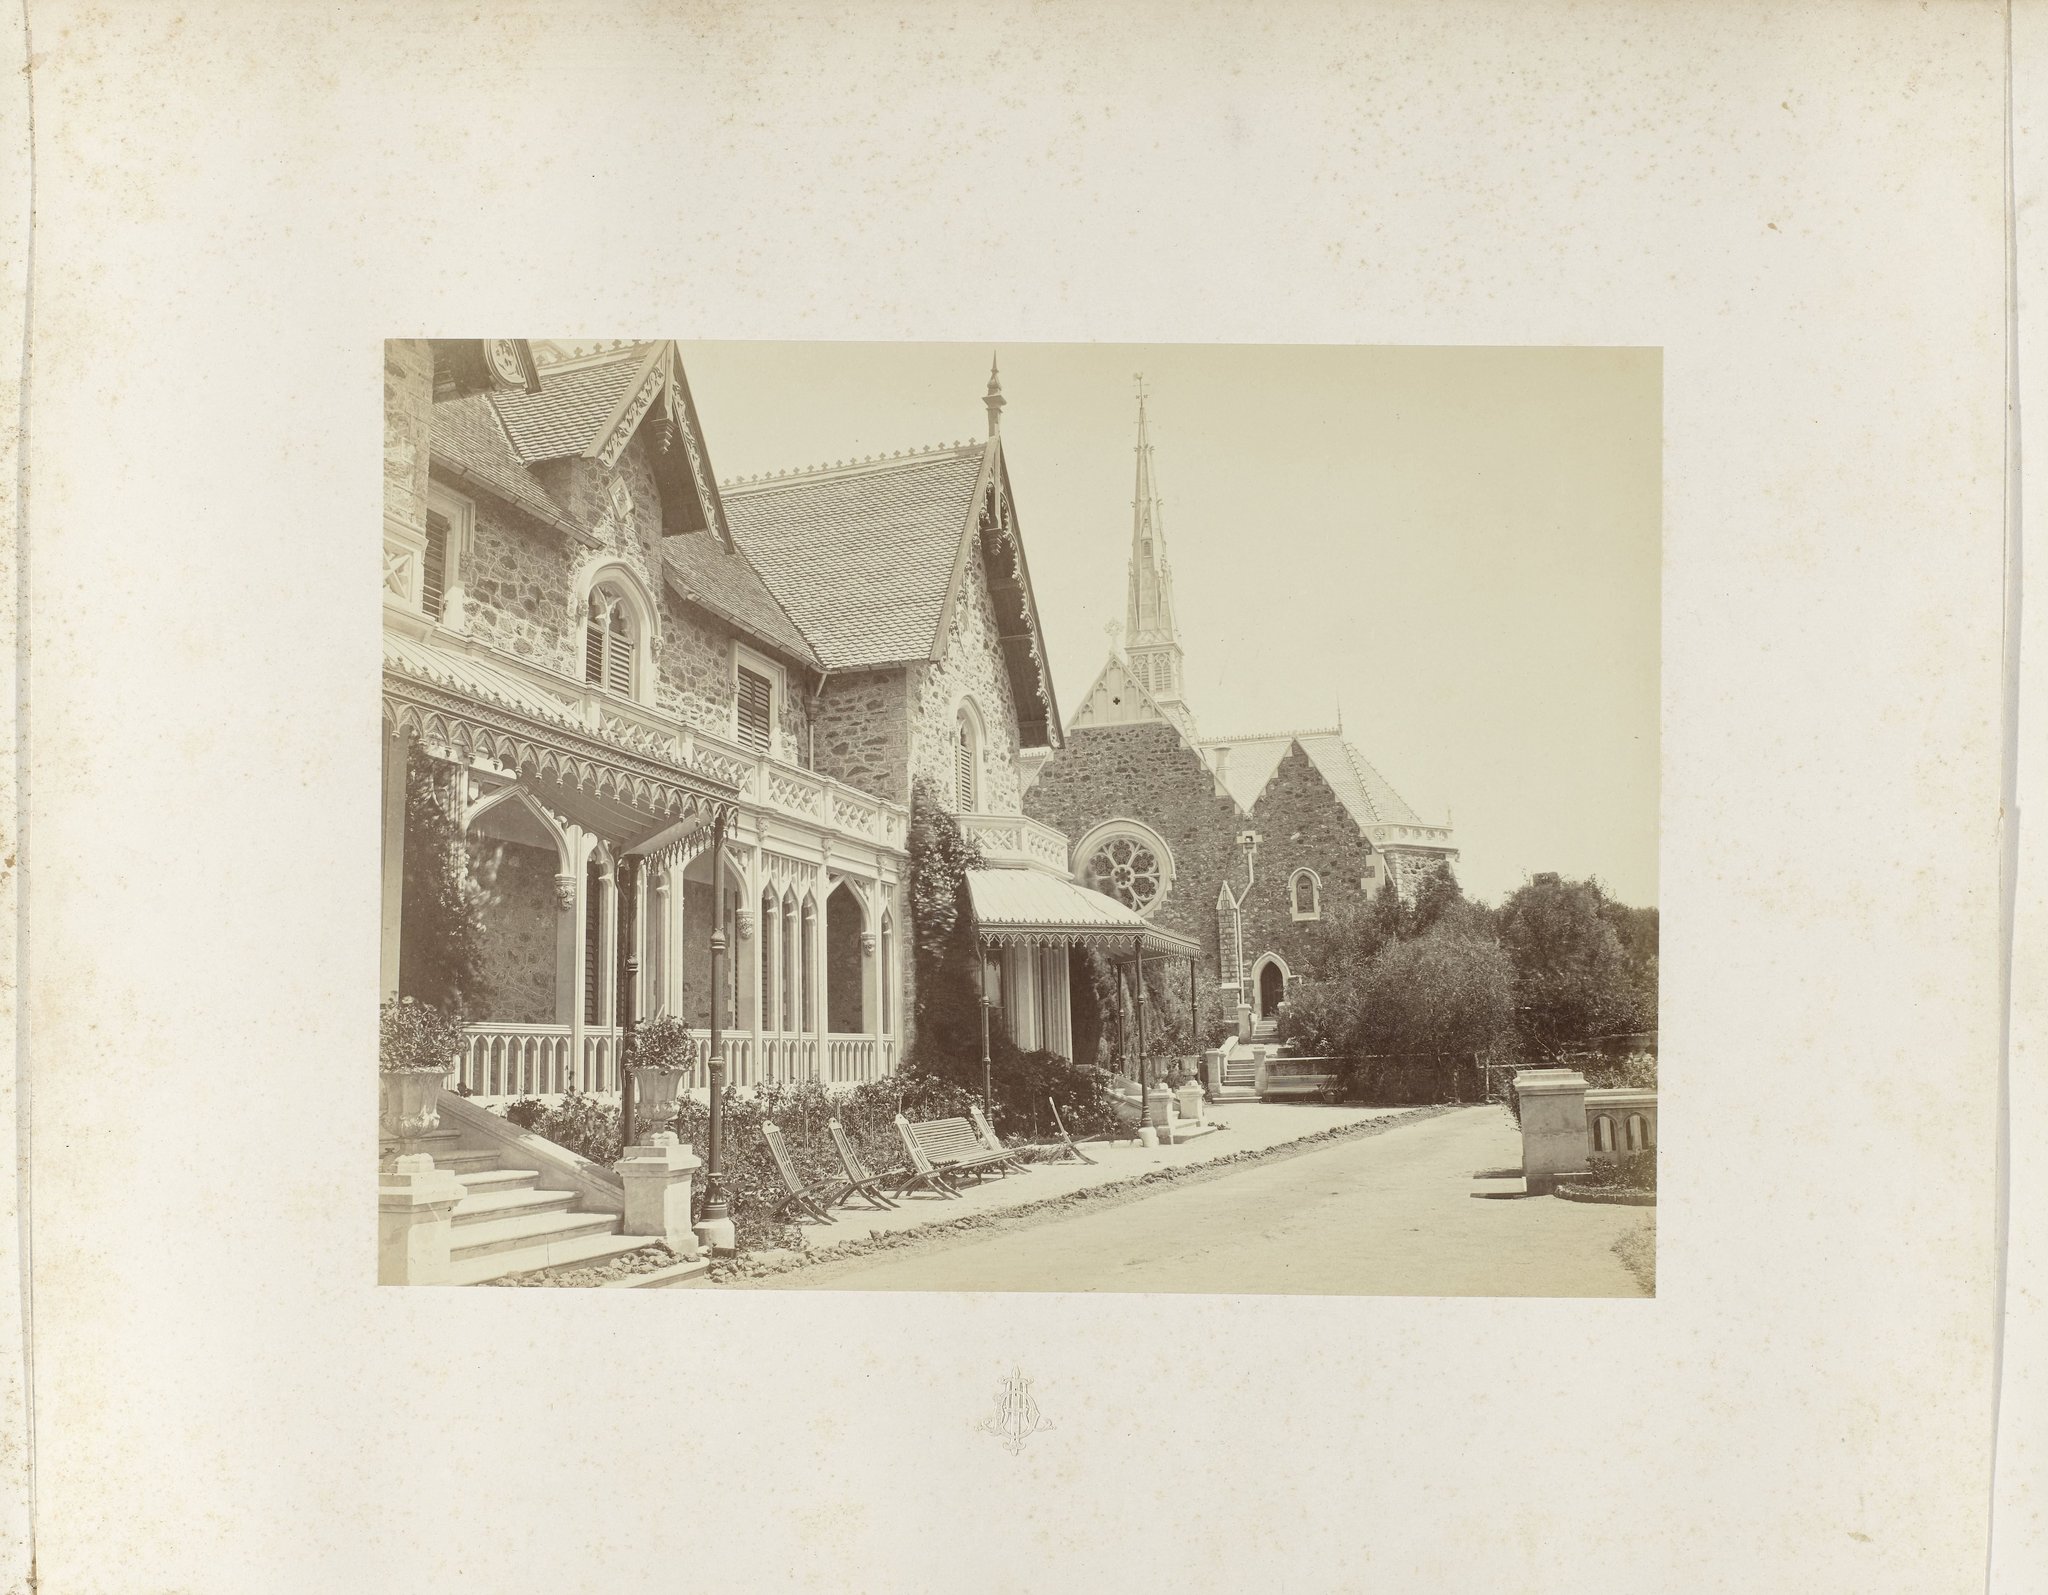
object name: photograph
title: Villa Victoria en de Anglicaanse Kerk te Cannes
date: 1868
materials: photographic support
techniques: albumen print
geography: cannes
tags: rural housing, e.g. country-house, villa, cottage, church (exterior)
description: Onderdeel van Reisalbum met opnames van kunstwerken, personen en bezienswaardigheden in Spanje.